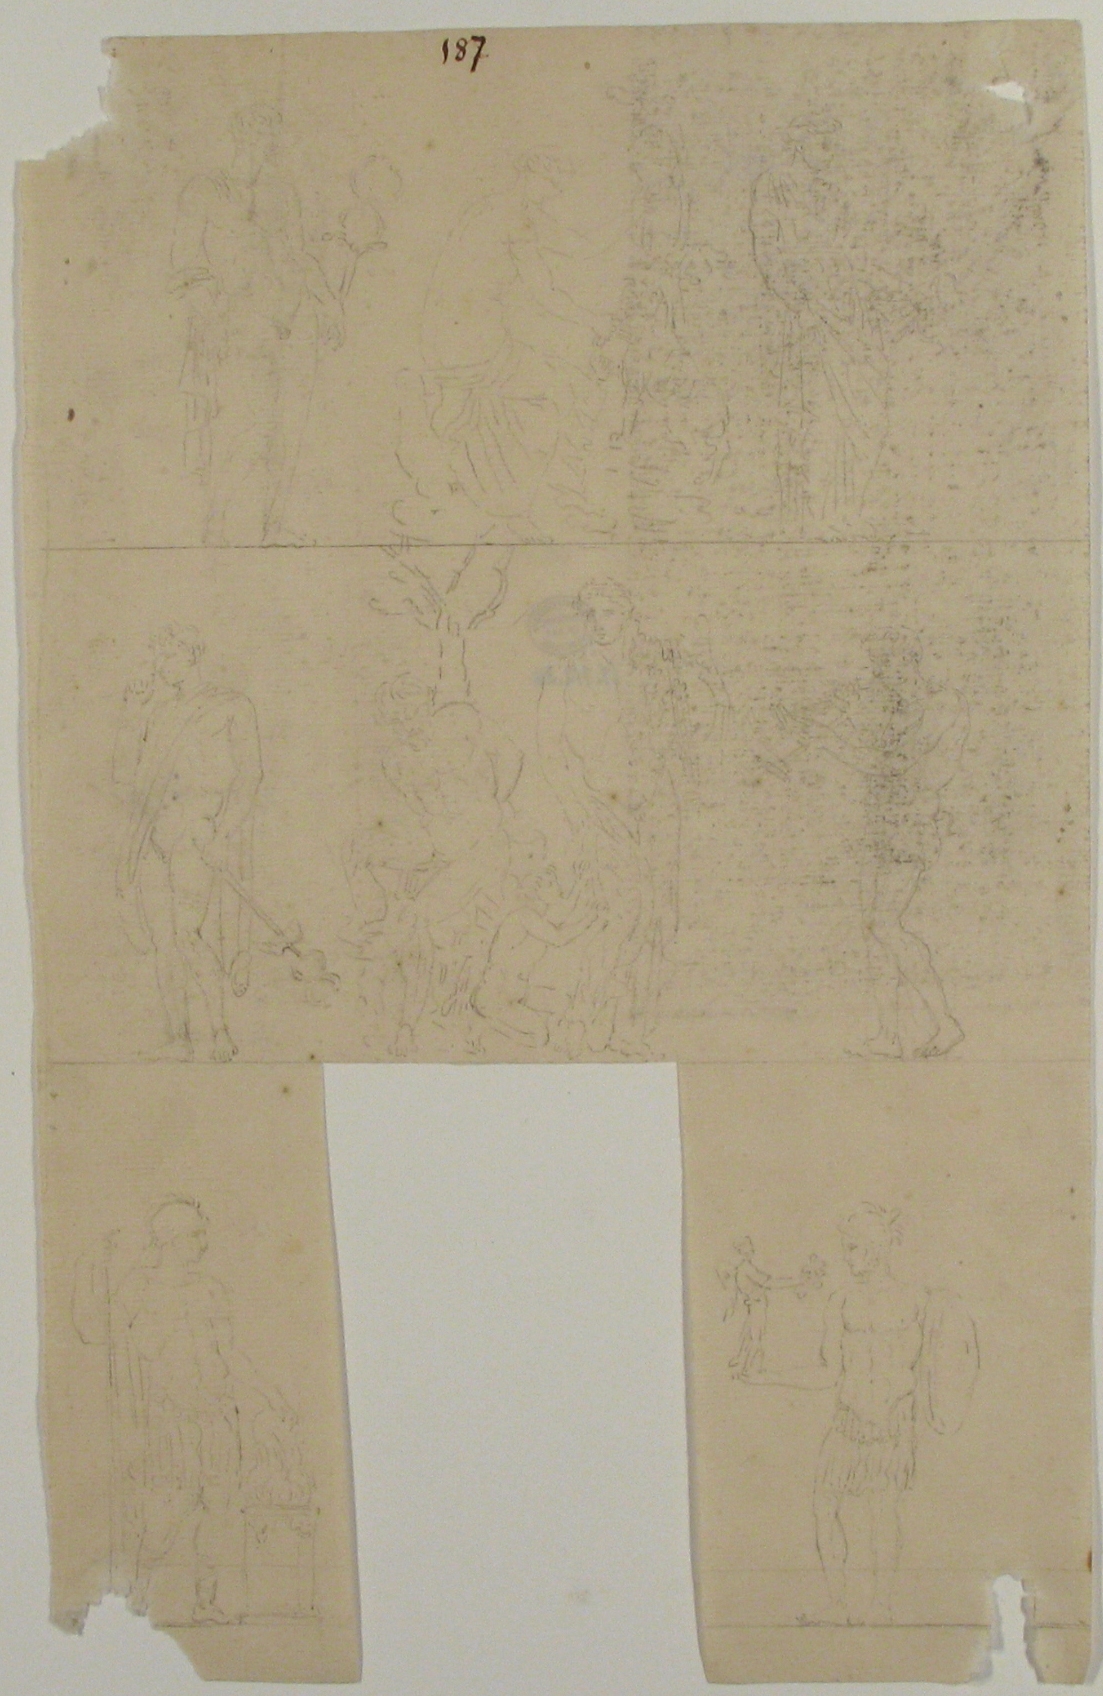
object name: drawing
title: Bacchic Scene; Two Roman Soldiers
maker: anonymous, french, 18th century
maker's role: artist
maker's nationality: french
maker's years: 1700-1800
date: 1701-1800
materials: graphite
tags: soldiers